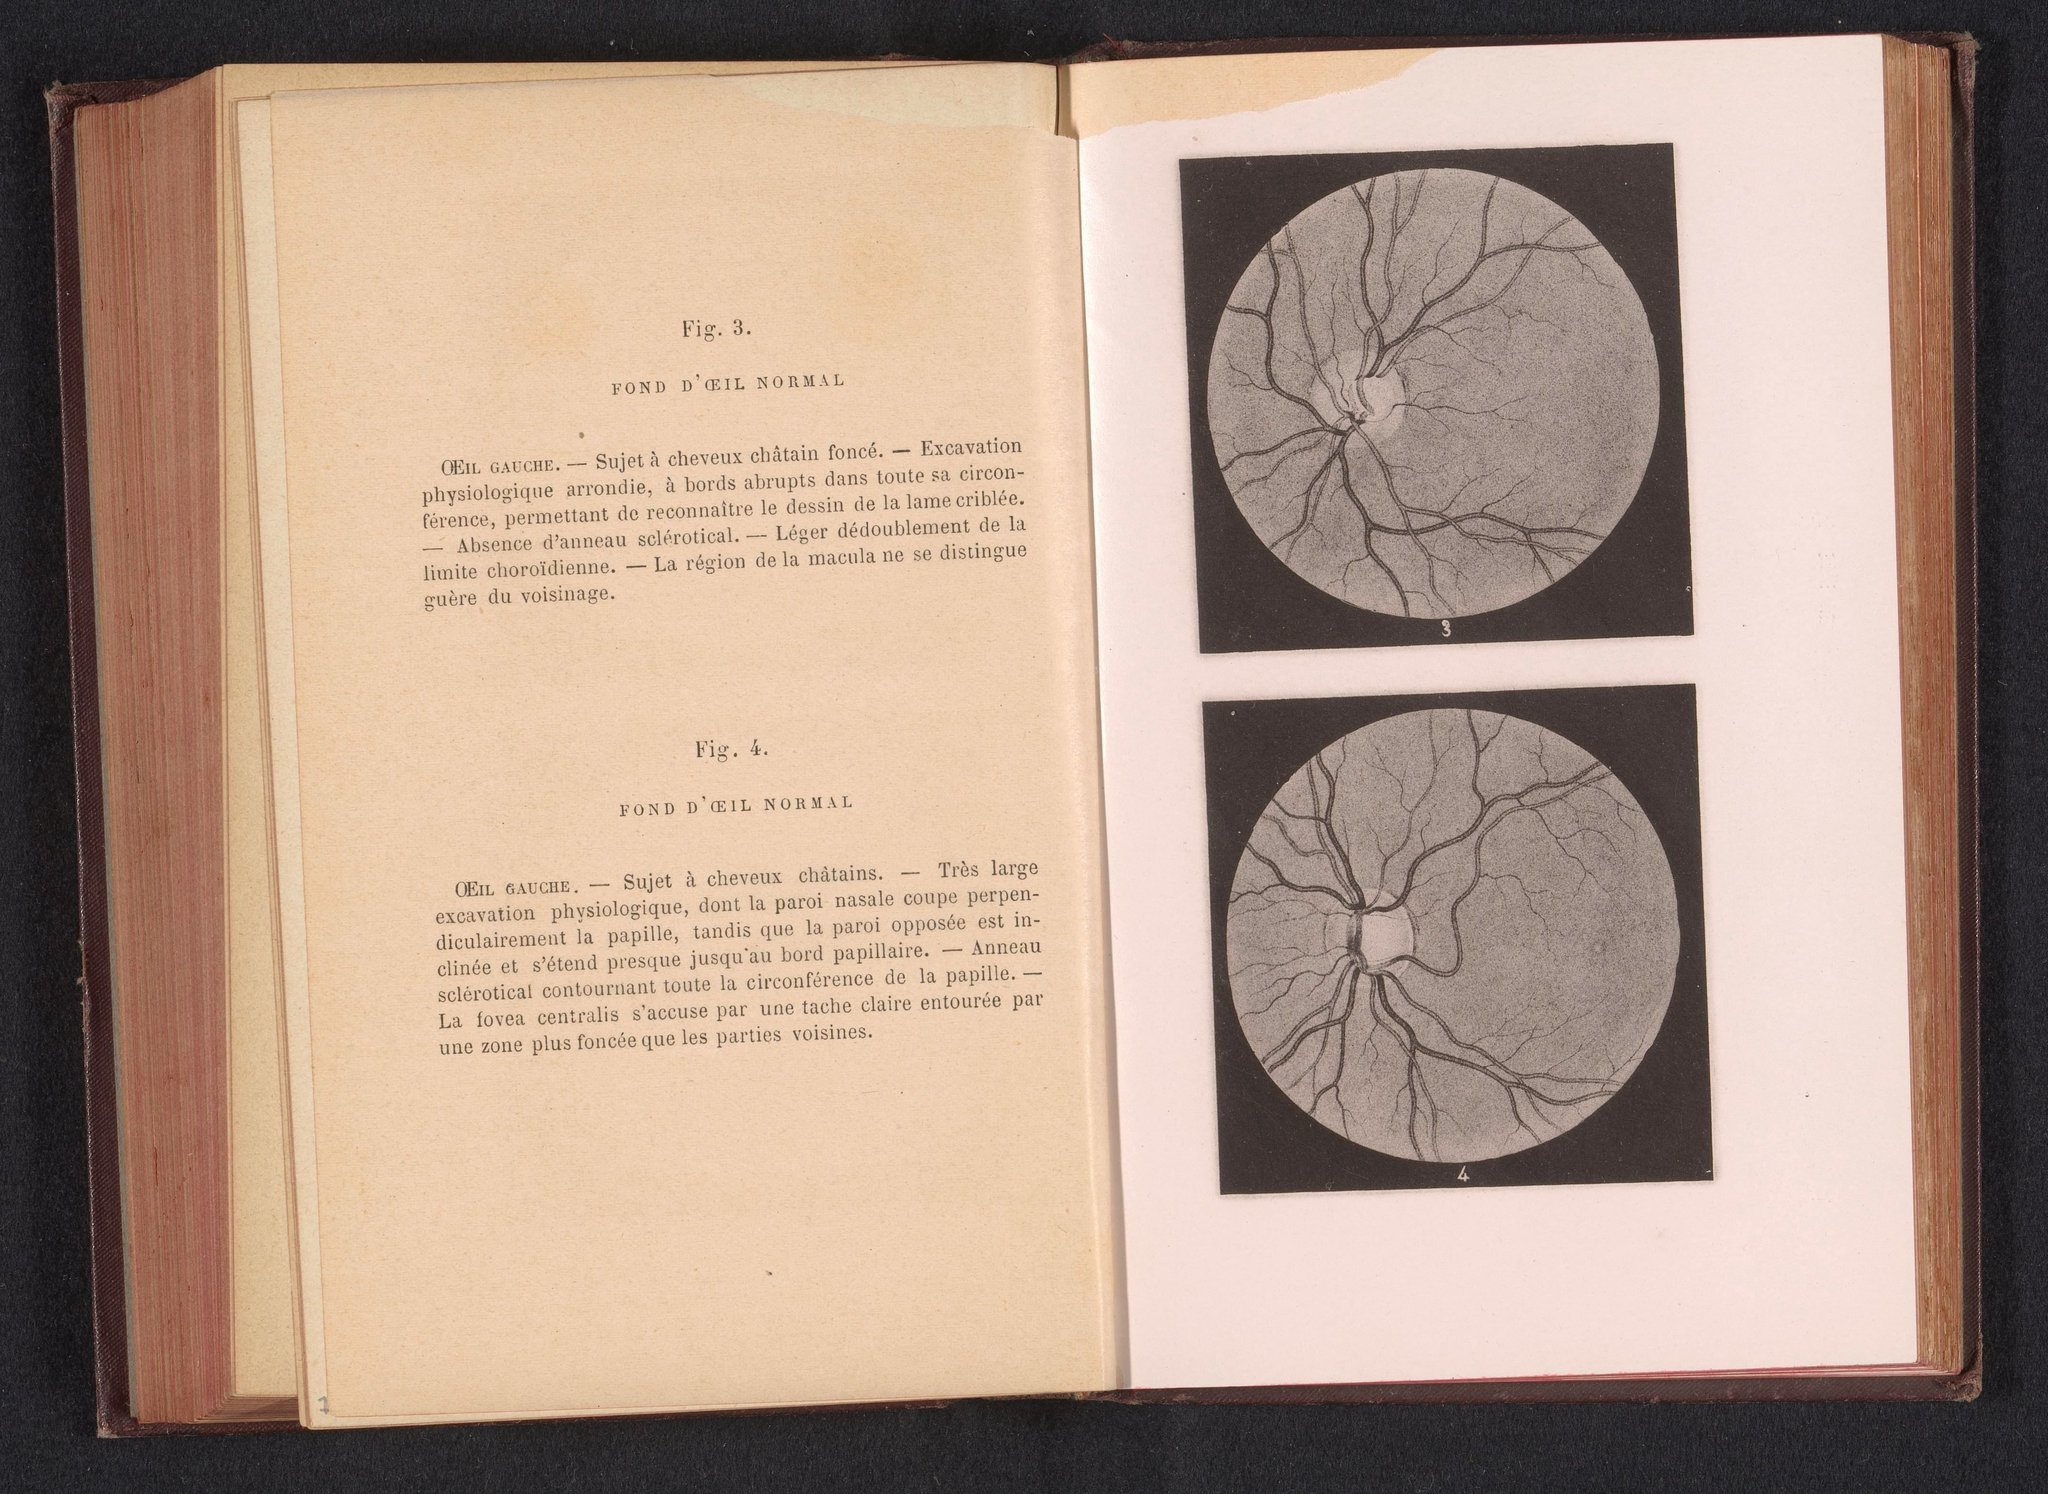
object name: photomechanical print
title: Fotoreproductie van twee anatomische tekeningen van een normaal oog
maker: Anonymous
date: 1871-1891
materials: paper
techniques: photograph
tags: anatomy (non-medical), eyes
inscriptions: inscription: ‘Fig. 3. Fond d'oeil normal Fig. 4. Fond d'oeil normal’